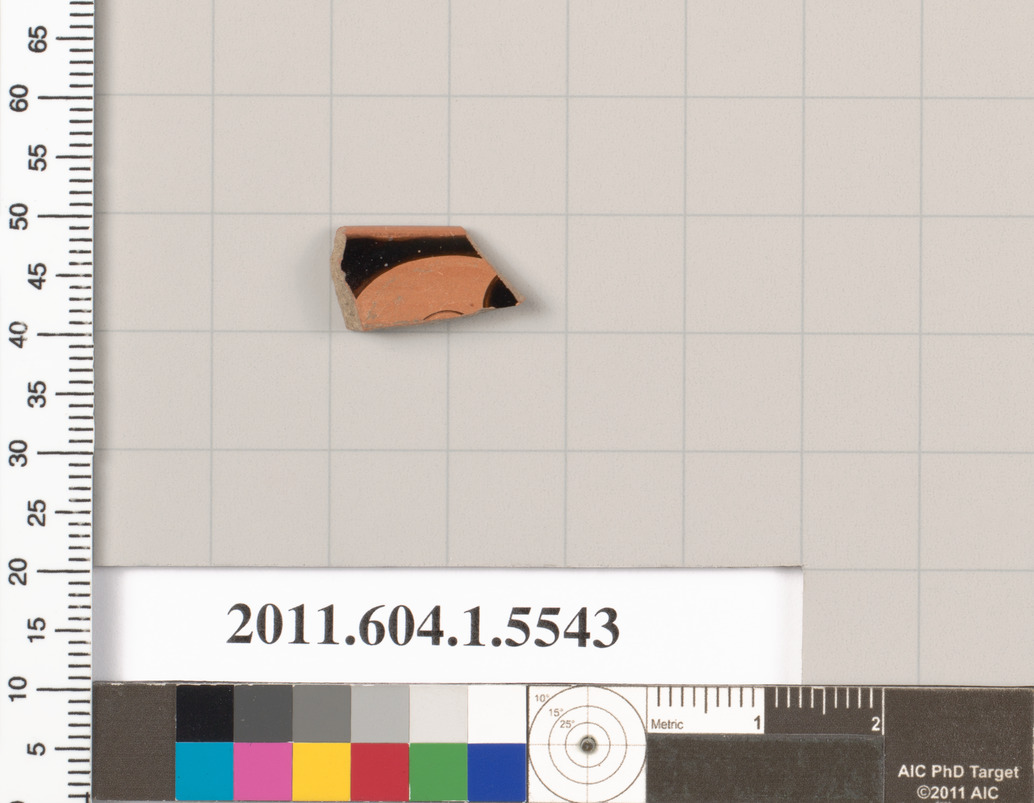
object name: kylix fragment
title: Terracotta rim fragment of a kylix (drinking cup)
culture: greek, attic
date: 510-490 BCE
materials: terracotta